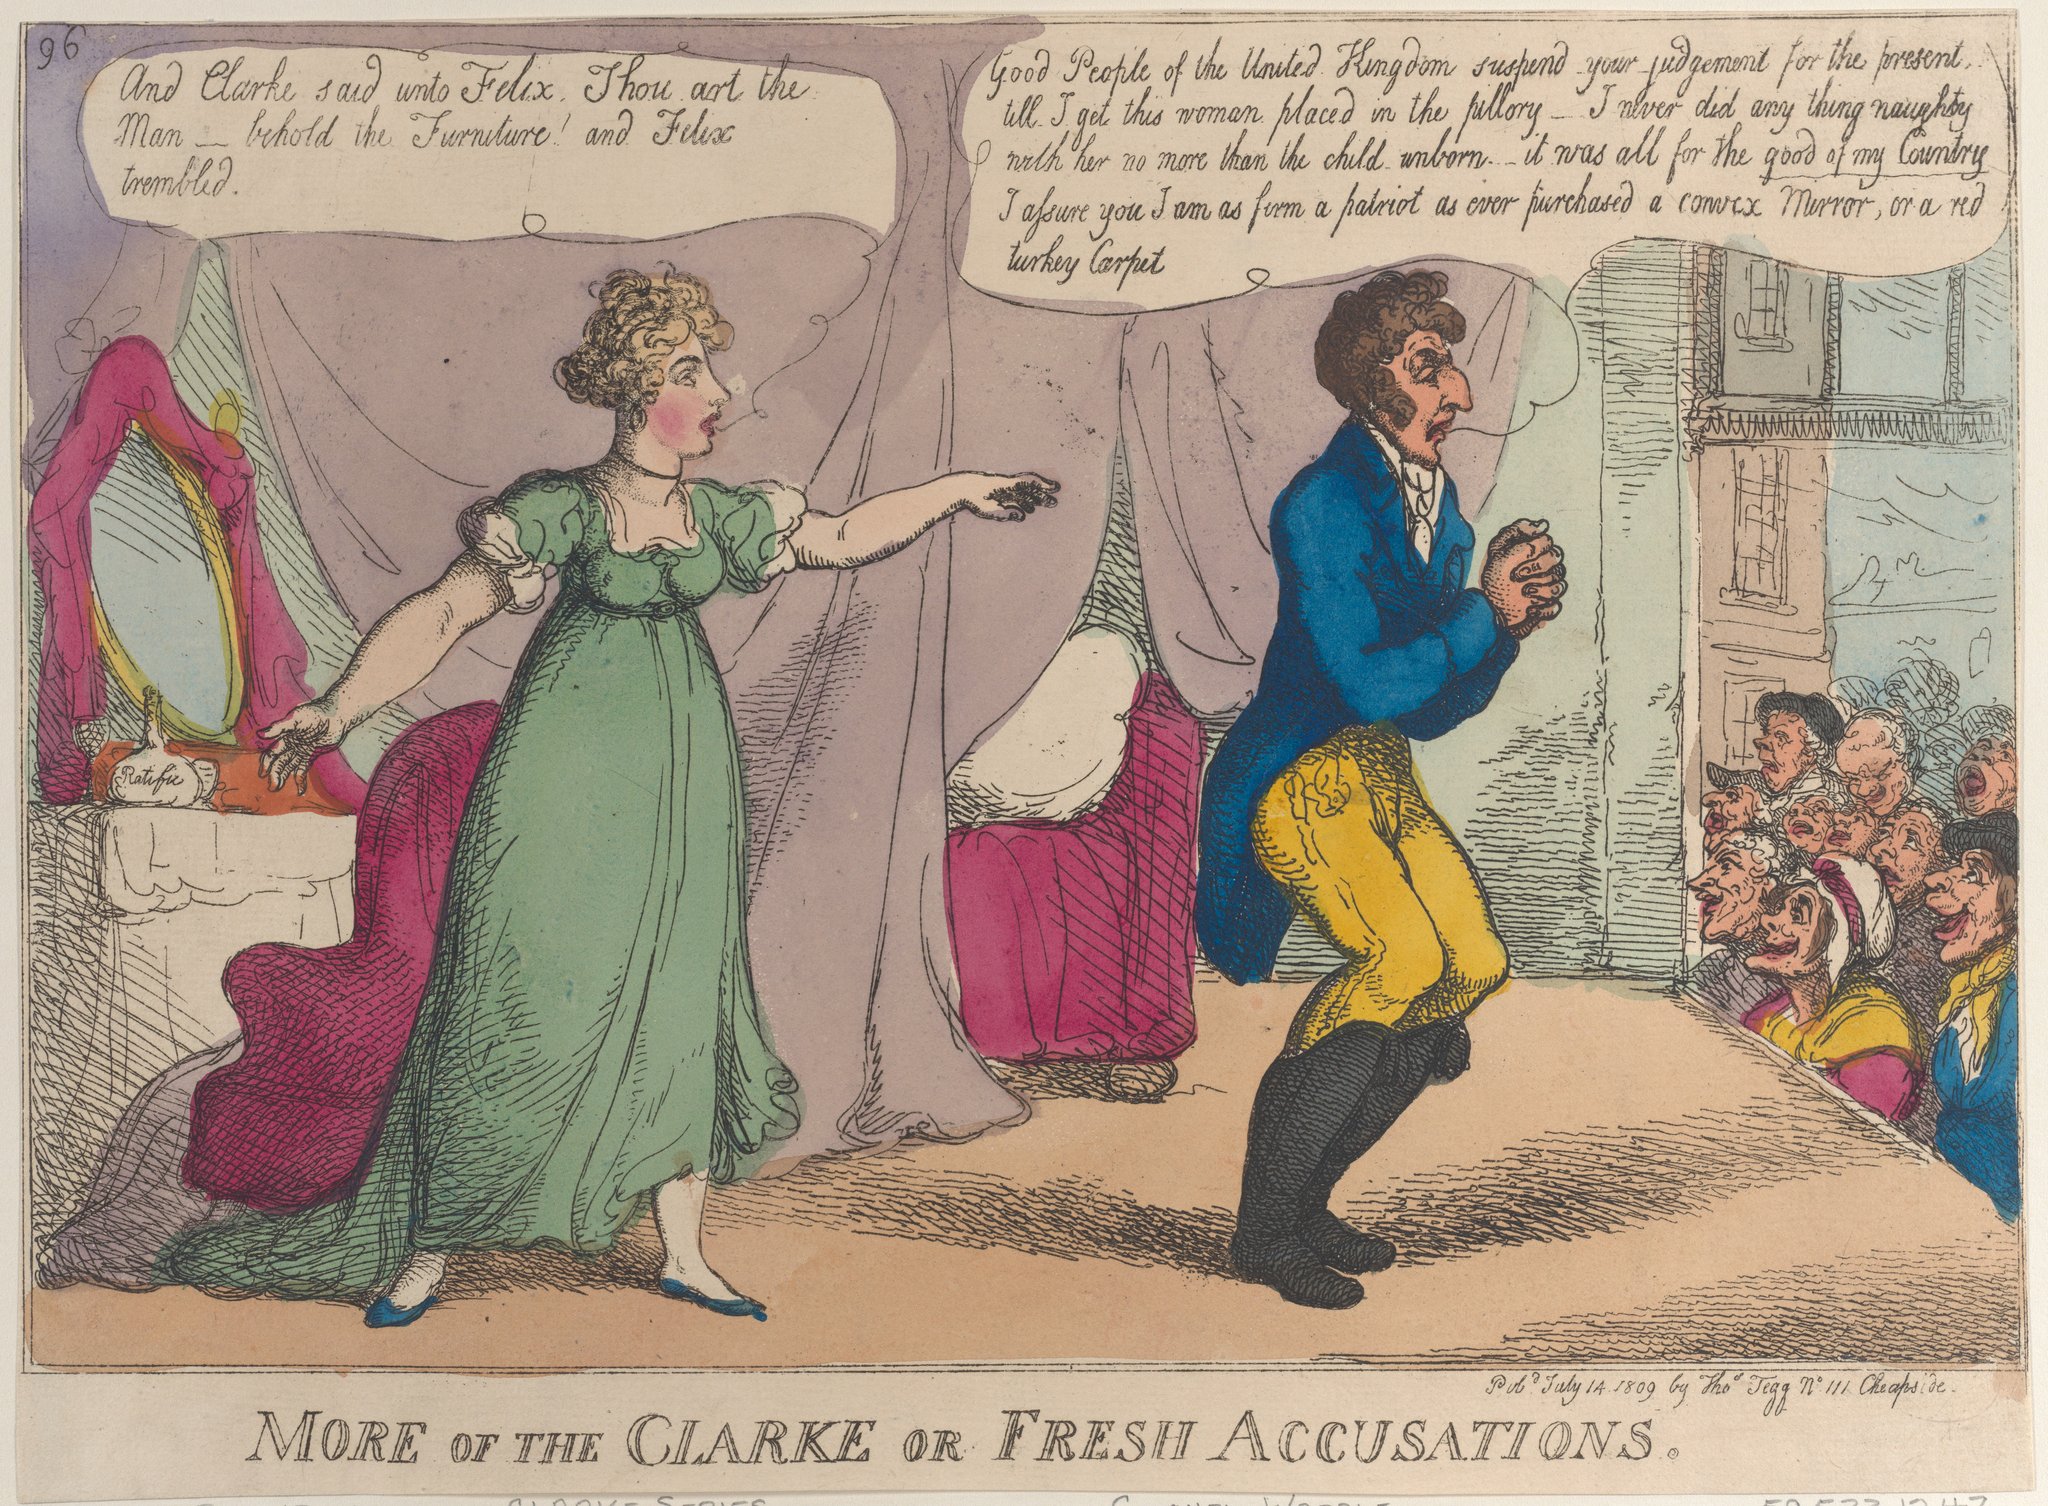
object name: print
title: More of the Clarke or Fresh Accusations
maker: thomas rowlandson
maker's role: artist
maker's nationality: british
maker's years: 1757-1827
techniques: etching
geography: london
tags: satire,men,women